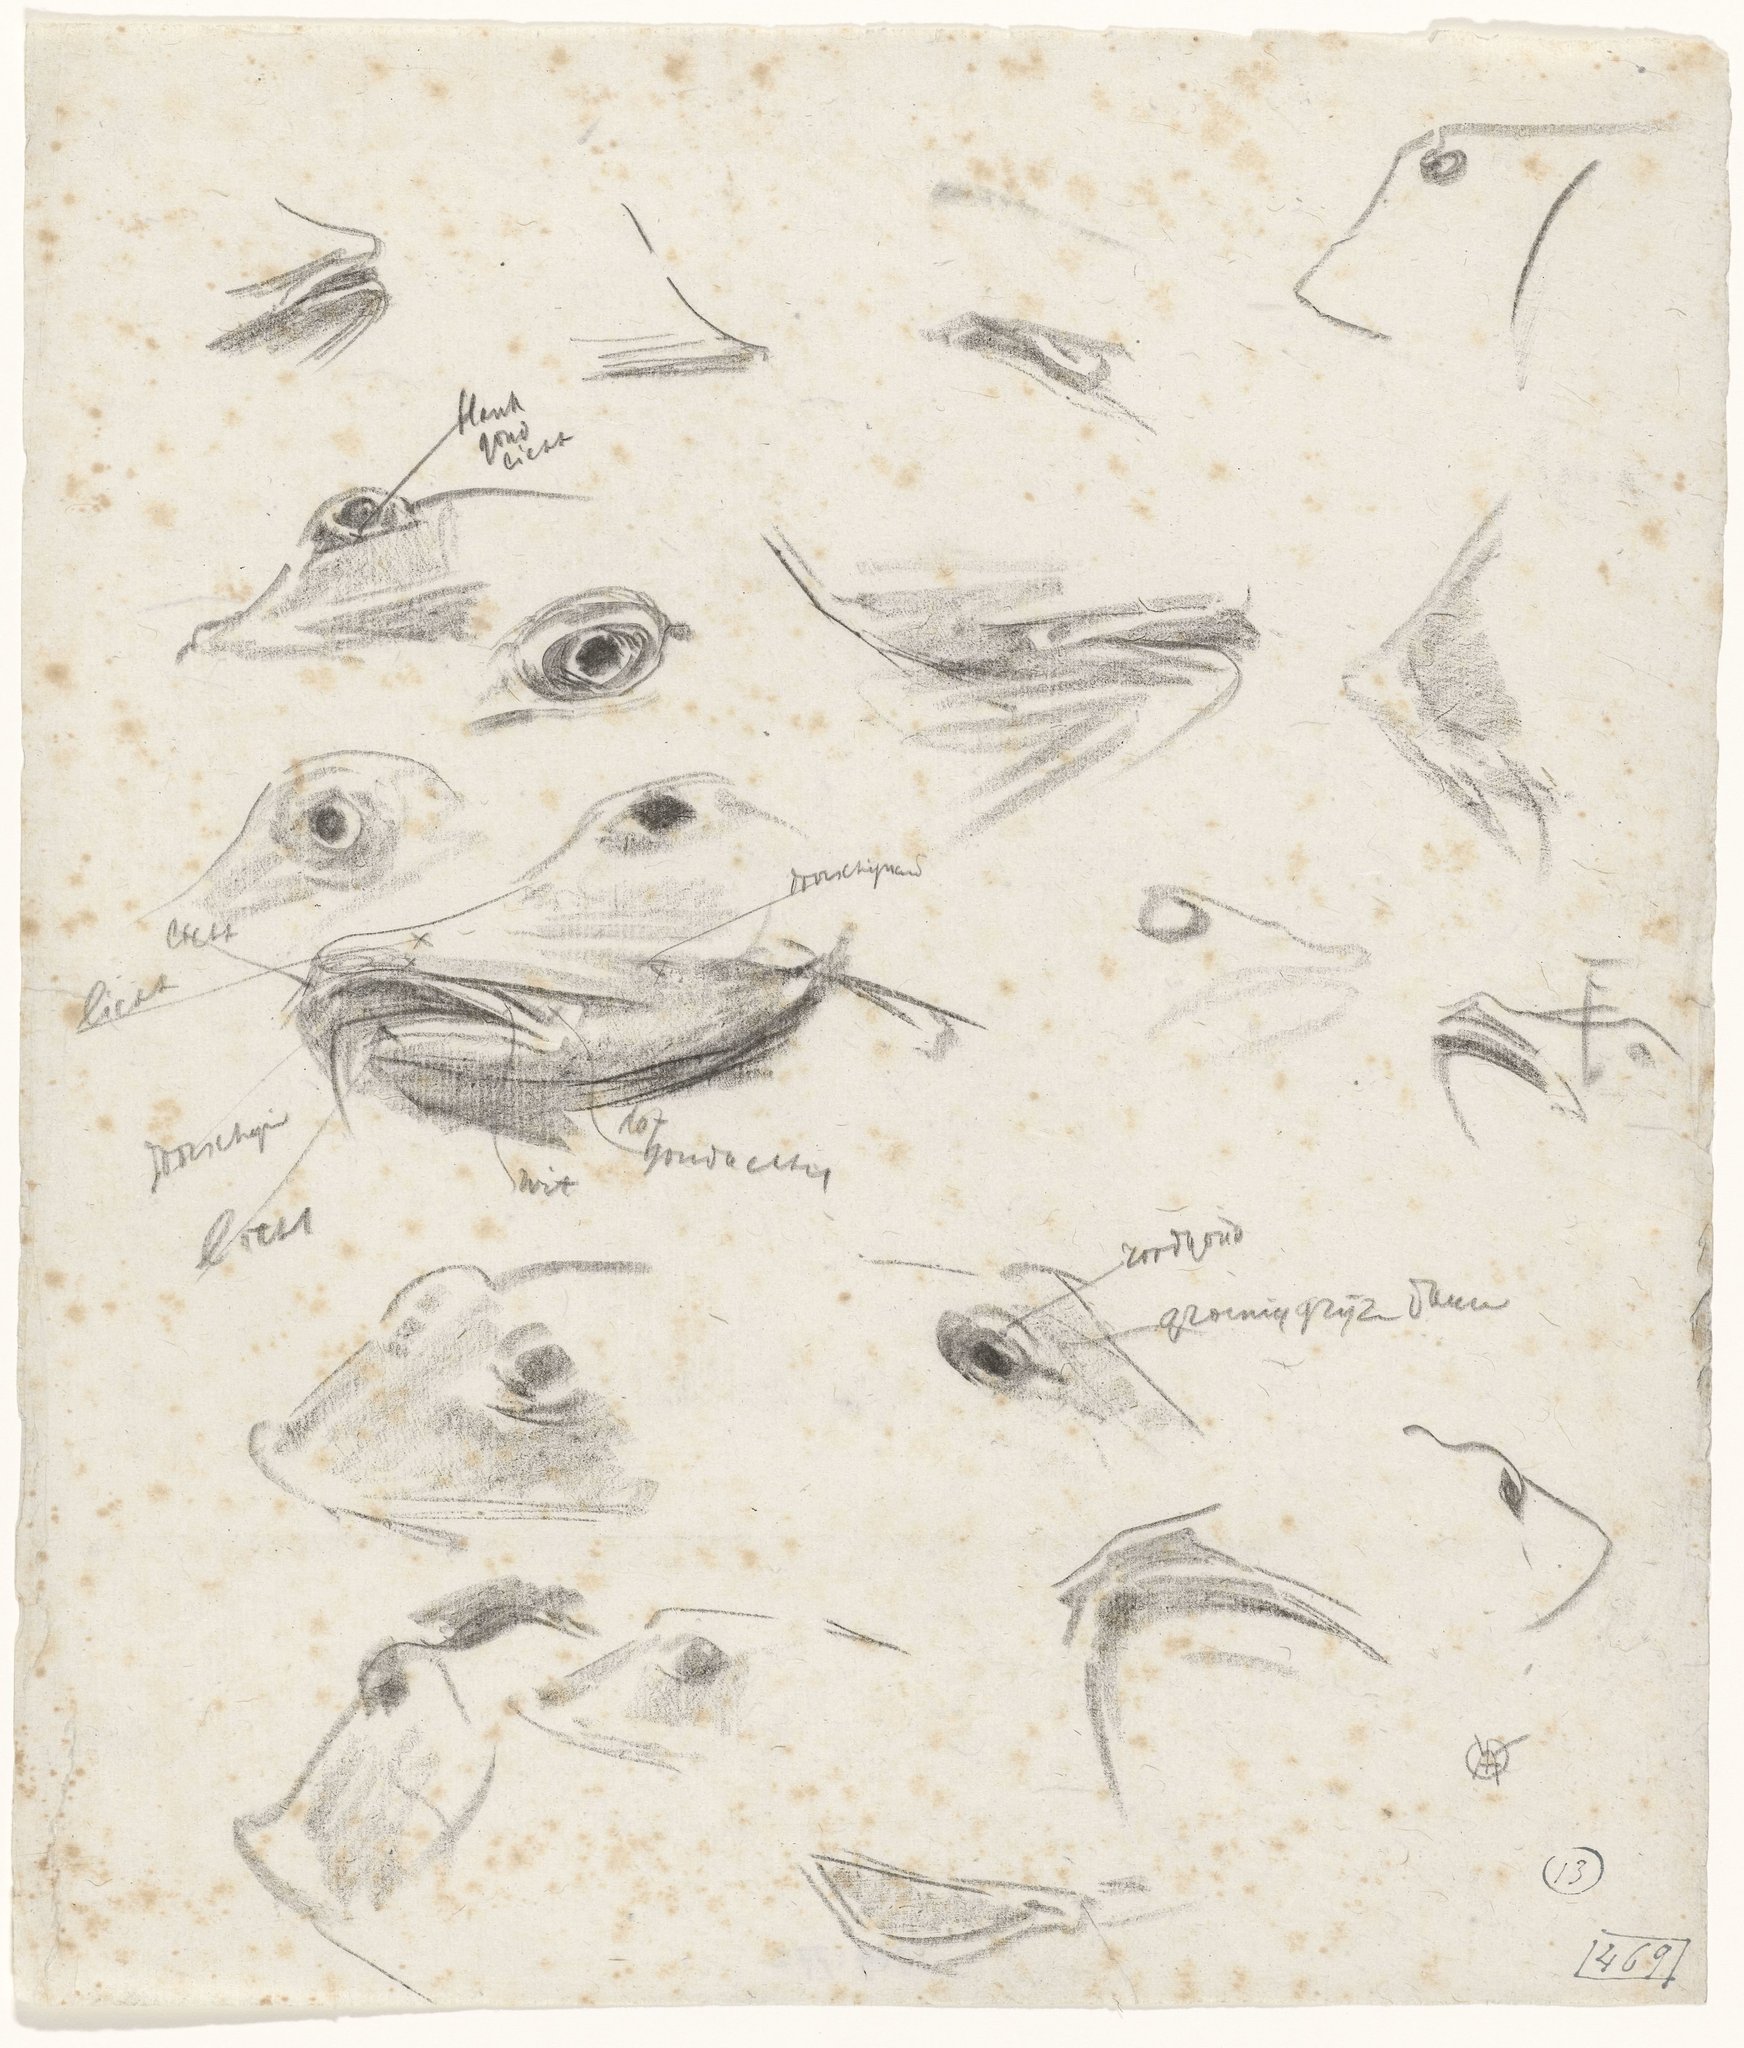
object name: drawing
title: Studies van koppen van ponen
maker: gerrit willem dijsselhof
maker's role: designer, draughtsman, print maker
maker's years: 1866-1924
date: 1876-1924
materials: chalk, paper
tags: bony fishes: gurnard